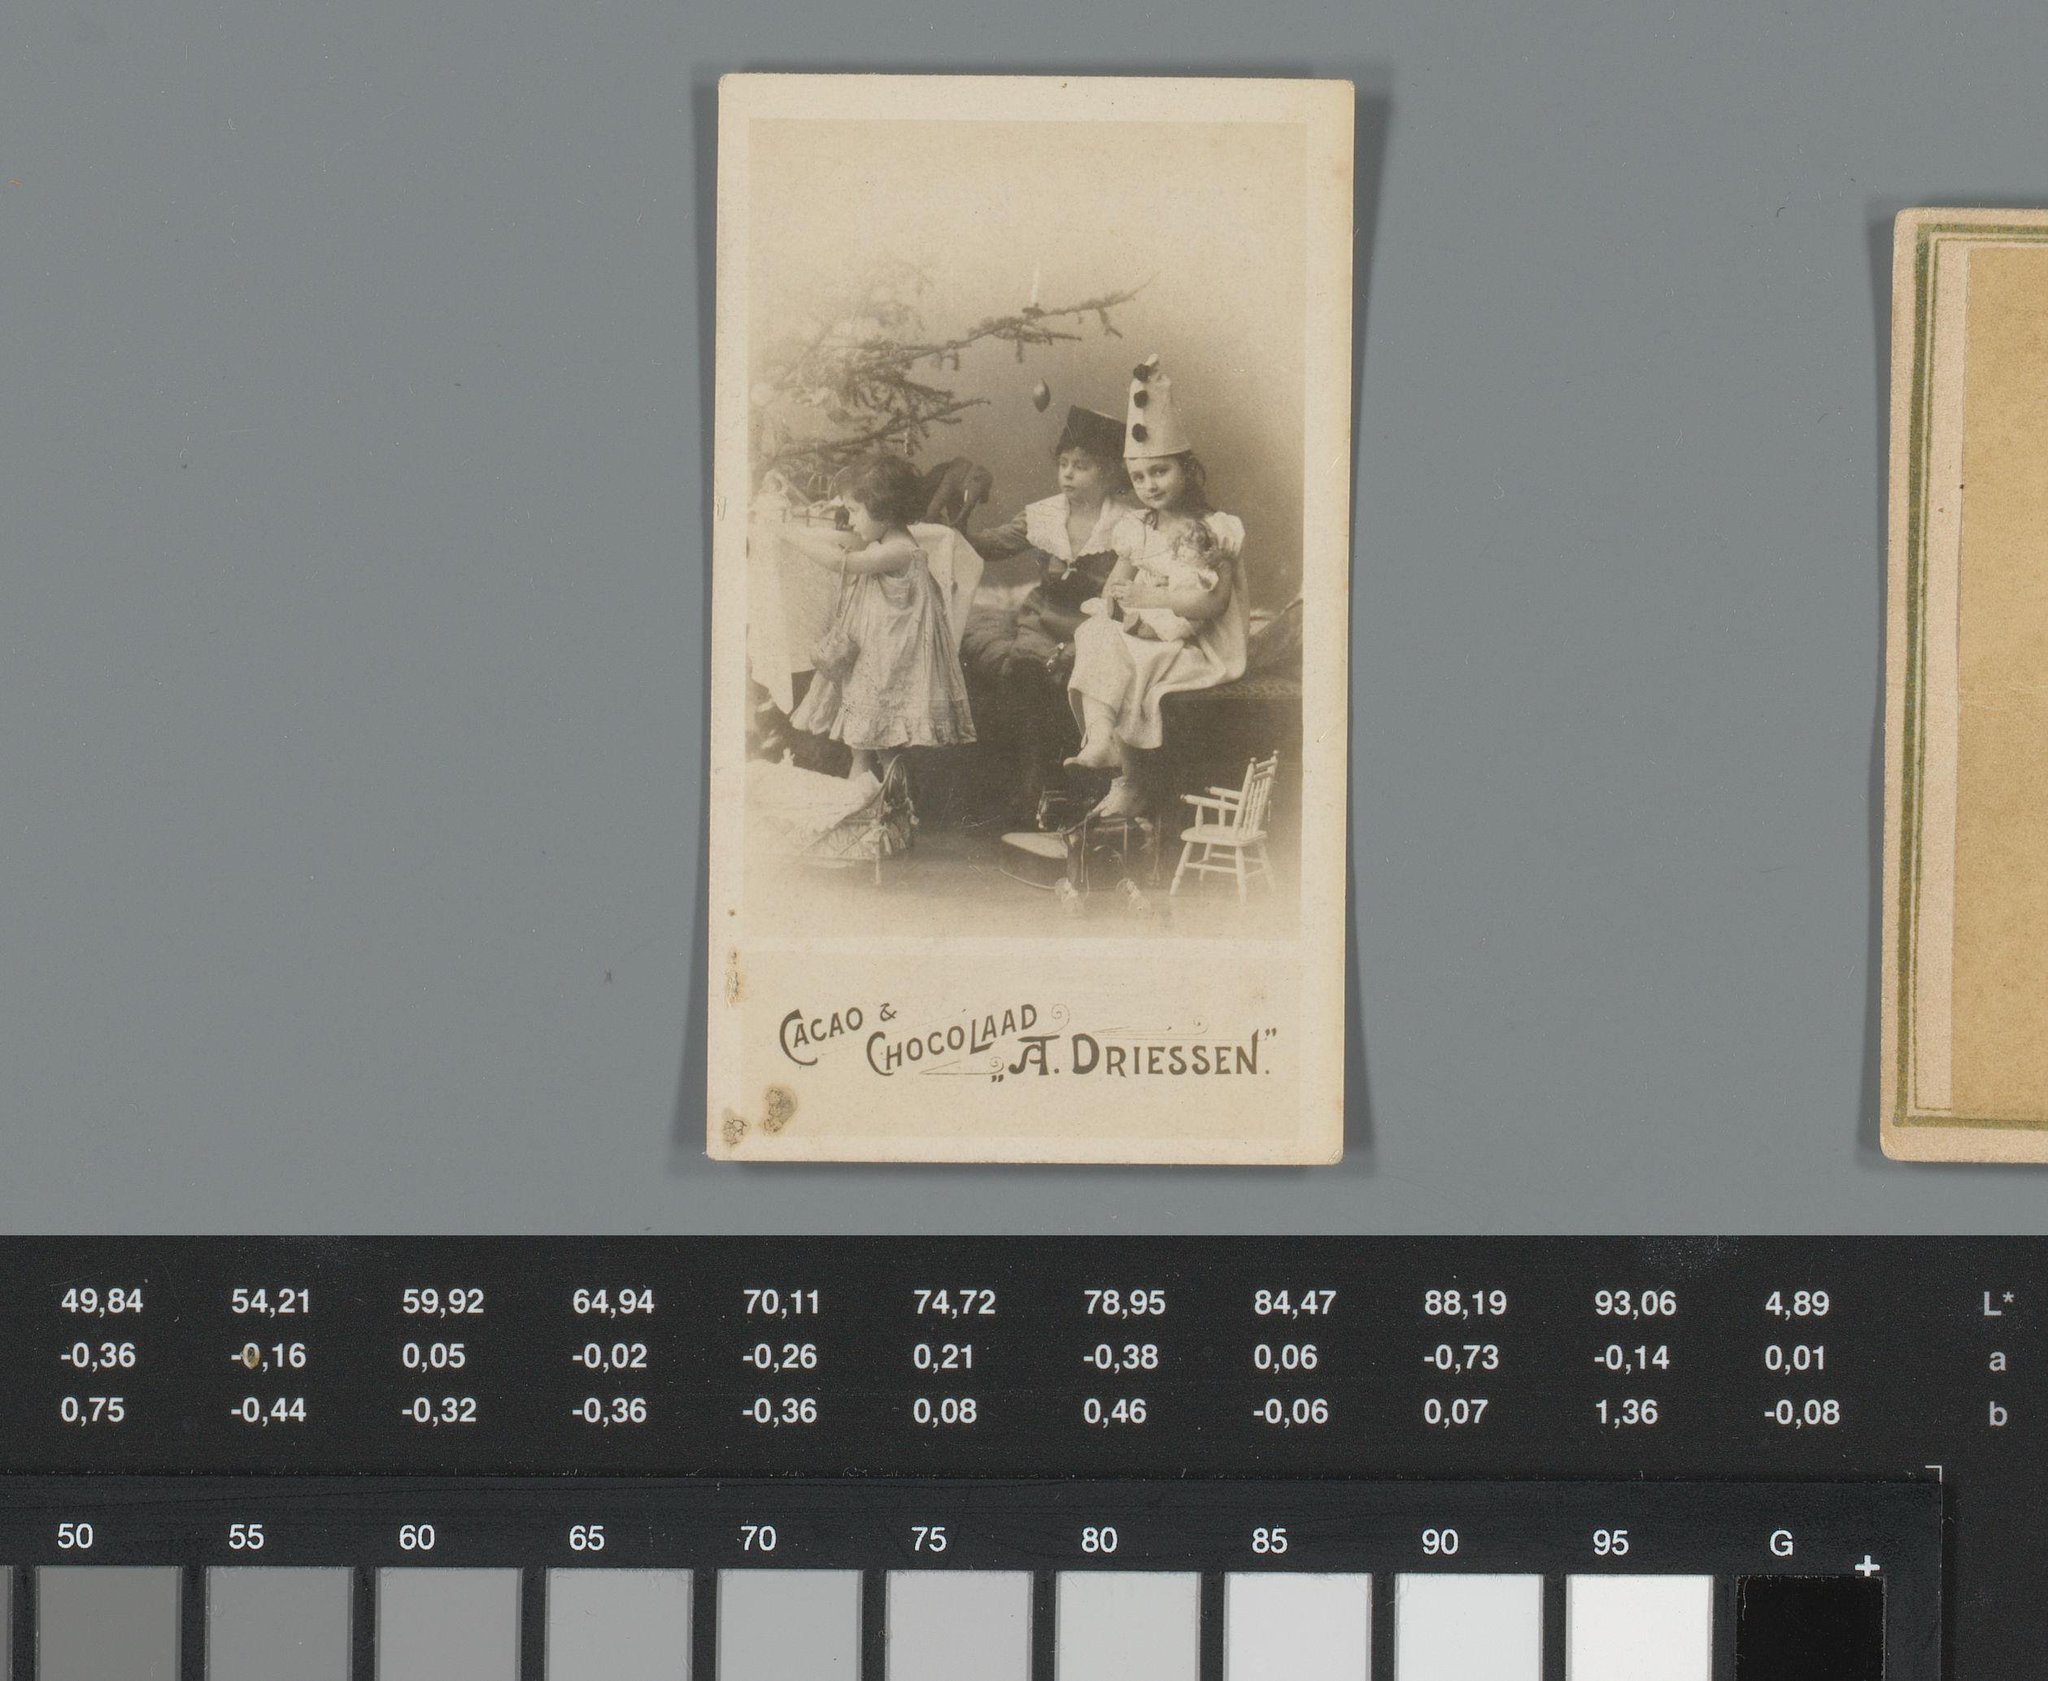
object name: photograph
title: Reclame voor cacao en chocola van A. Driessen met portret van drie kinderen bij een kerstboom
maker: Anonymous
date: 1880-1915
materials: paper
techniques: gelatin silver print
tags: chocolate, cocoa, advertising, christmas tree, child, historical persons not known by name